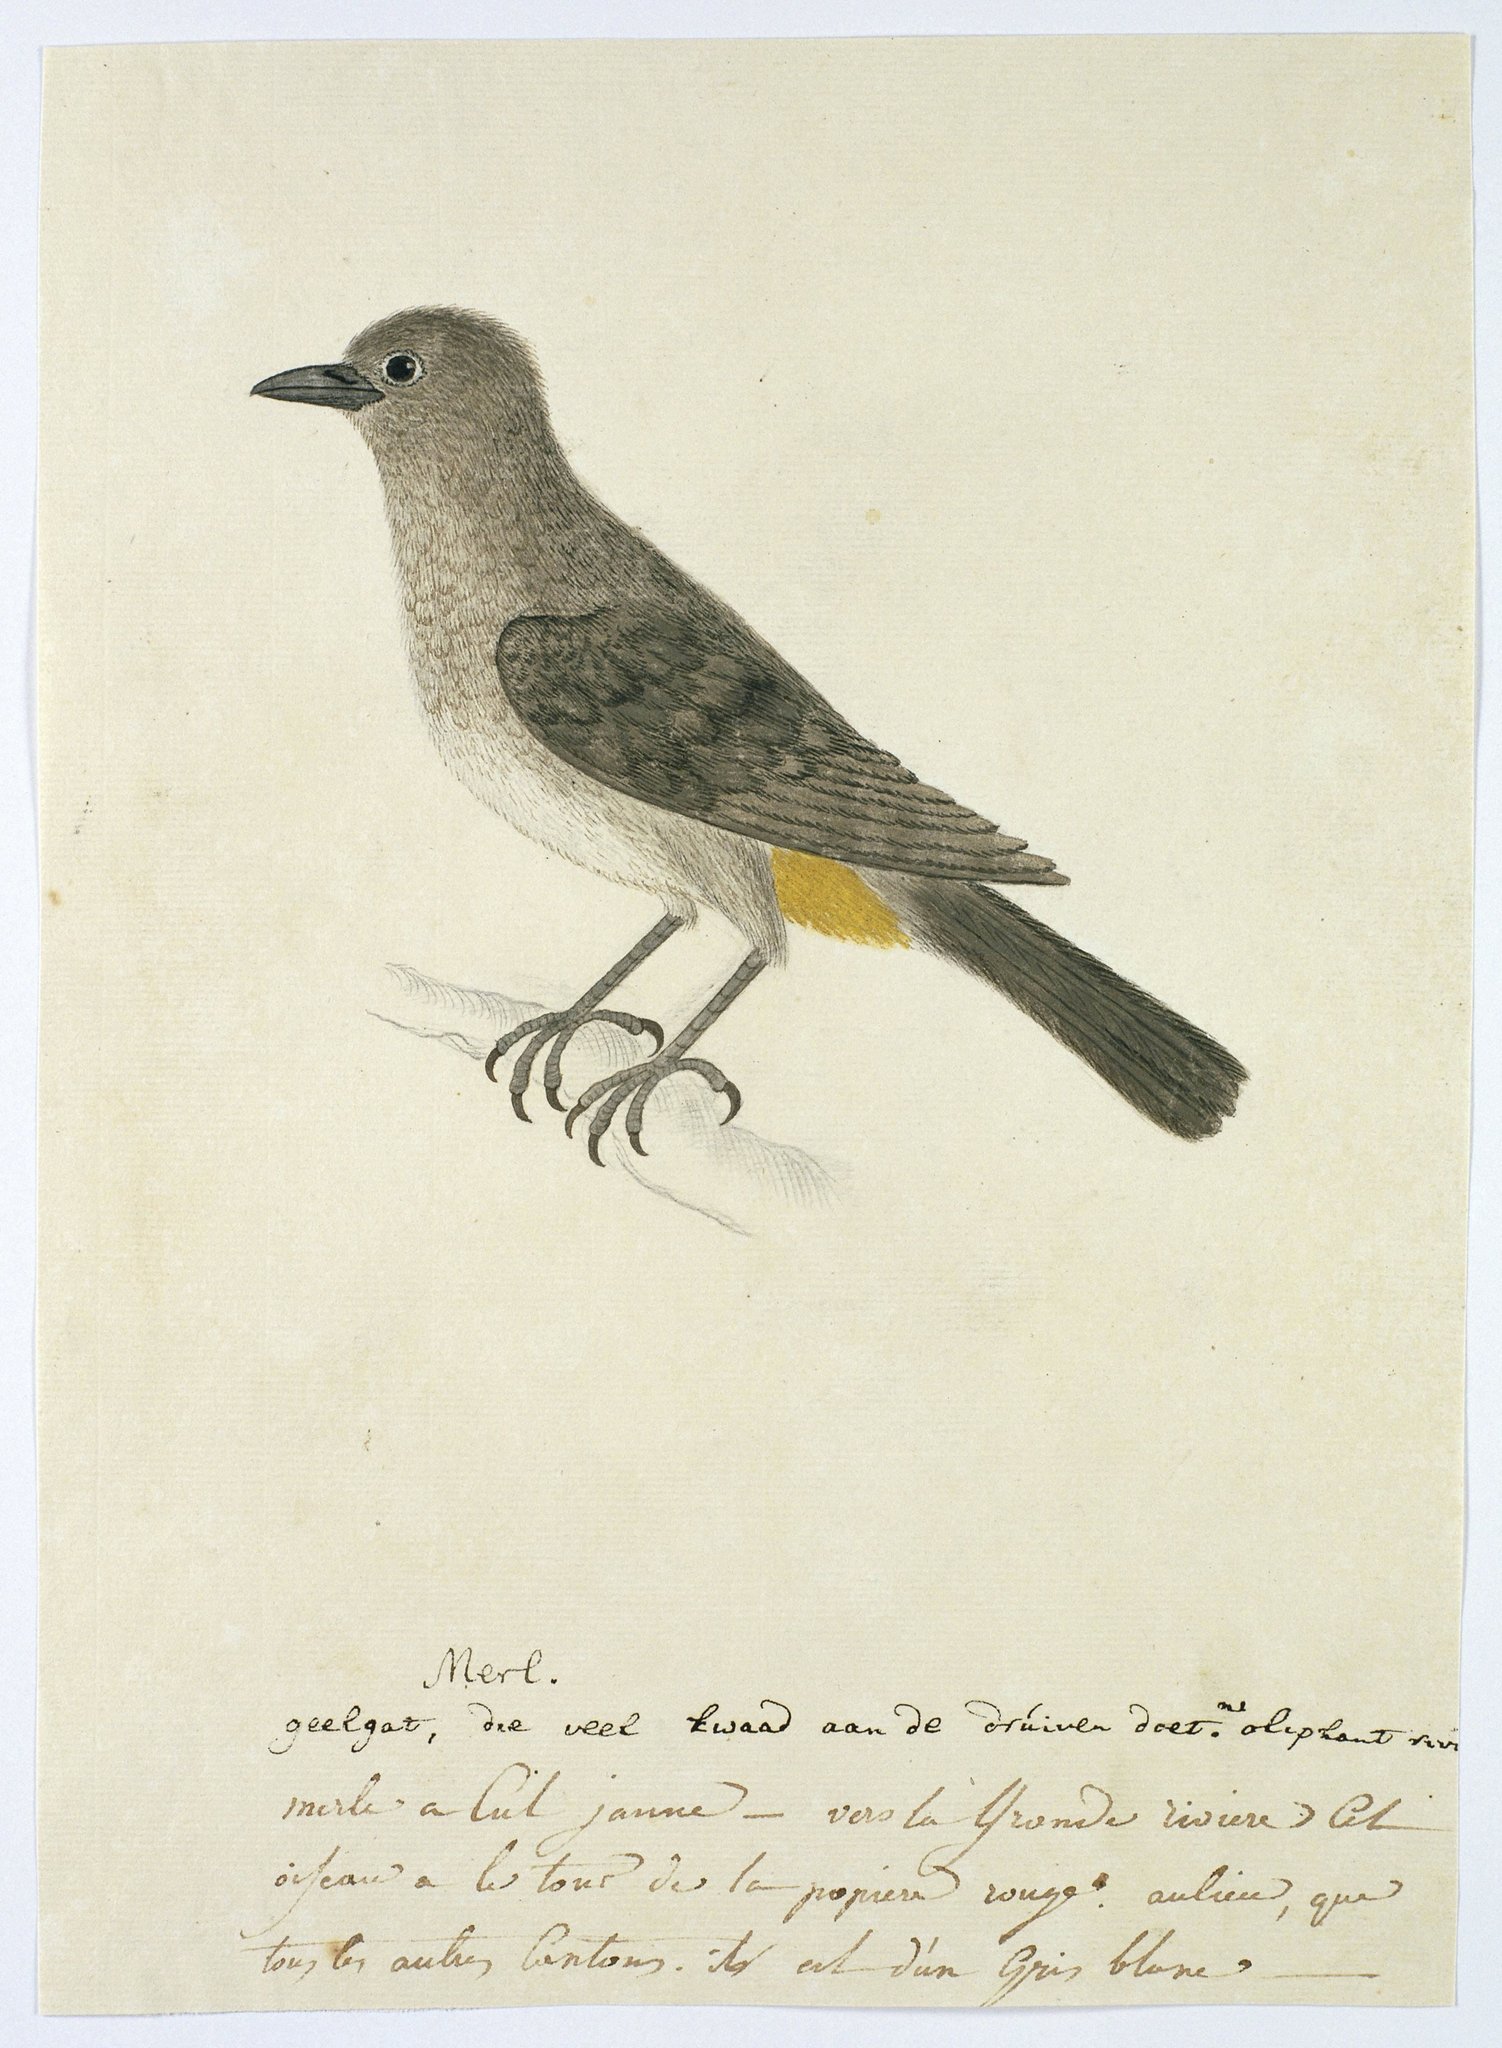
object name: album leaf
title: Pycnonotus capensis (Cape bulbul)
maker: robert jacob gordon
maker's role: draughtsman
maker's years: 1743-1795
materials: chalk, ink, paper, pencil, watercolor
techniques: brush, pen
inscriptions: annotation: ‘Merl. / geelgat, [...]. oliphant rivi[er] afgesneden’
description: Vogelstudie: Kaapse buulbuul (Pycnonotus capensis); leeft in de omgeving van de grote rivieren (Olifantsrivier).